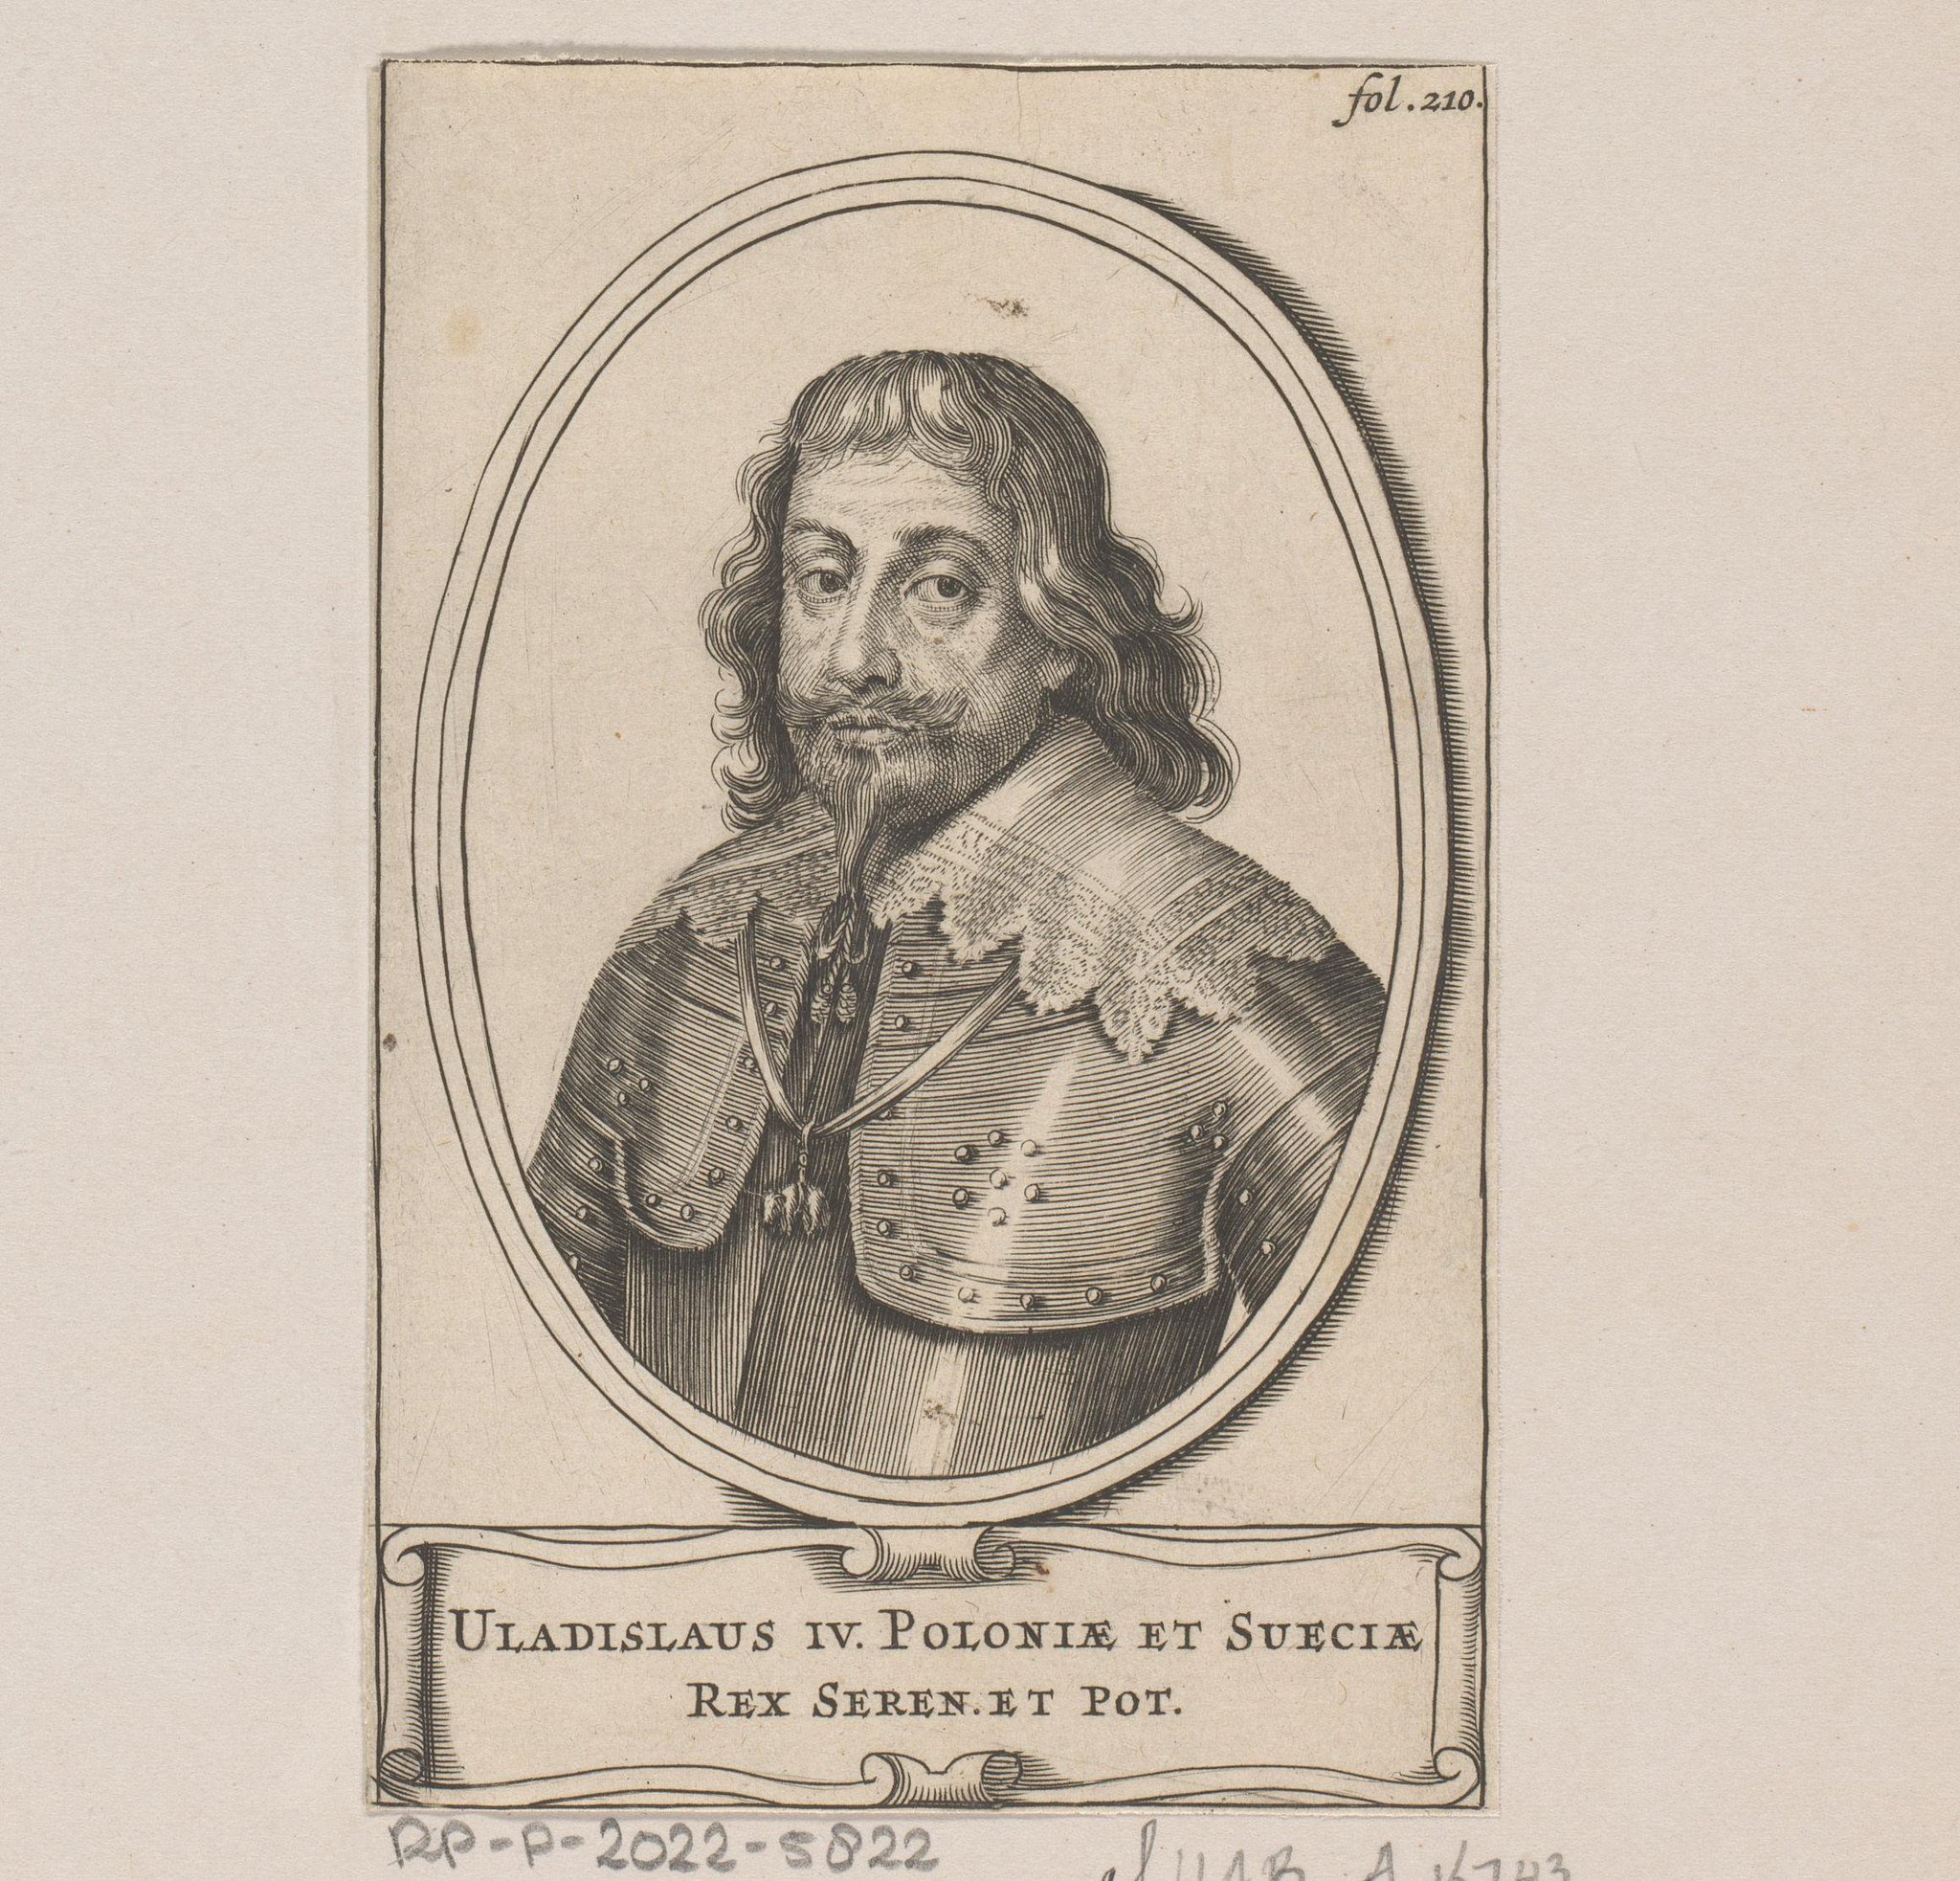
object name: book illustration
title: Portret van Wladislaus IV van Polen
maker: Anonymous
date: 1647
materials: paper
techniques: engraving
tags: wladislaus wasa (iv), historical persons, knighthood order of the golden fleece, ruler, sovereign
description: Prent waarschijnlijk uit: Wassenbergh, Everhard. Duytsche Florus, begrypende de Duytsche oorlogen, met den aenvangh van het (...). Amsterdam: Nicolaes van Ravesteyn, 1647.